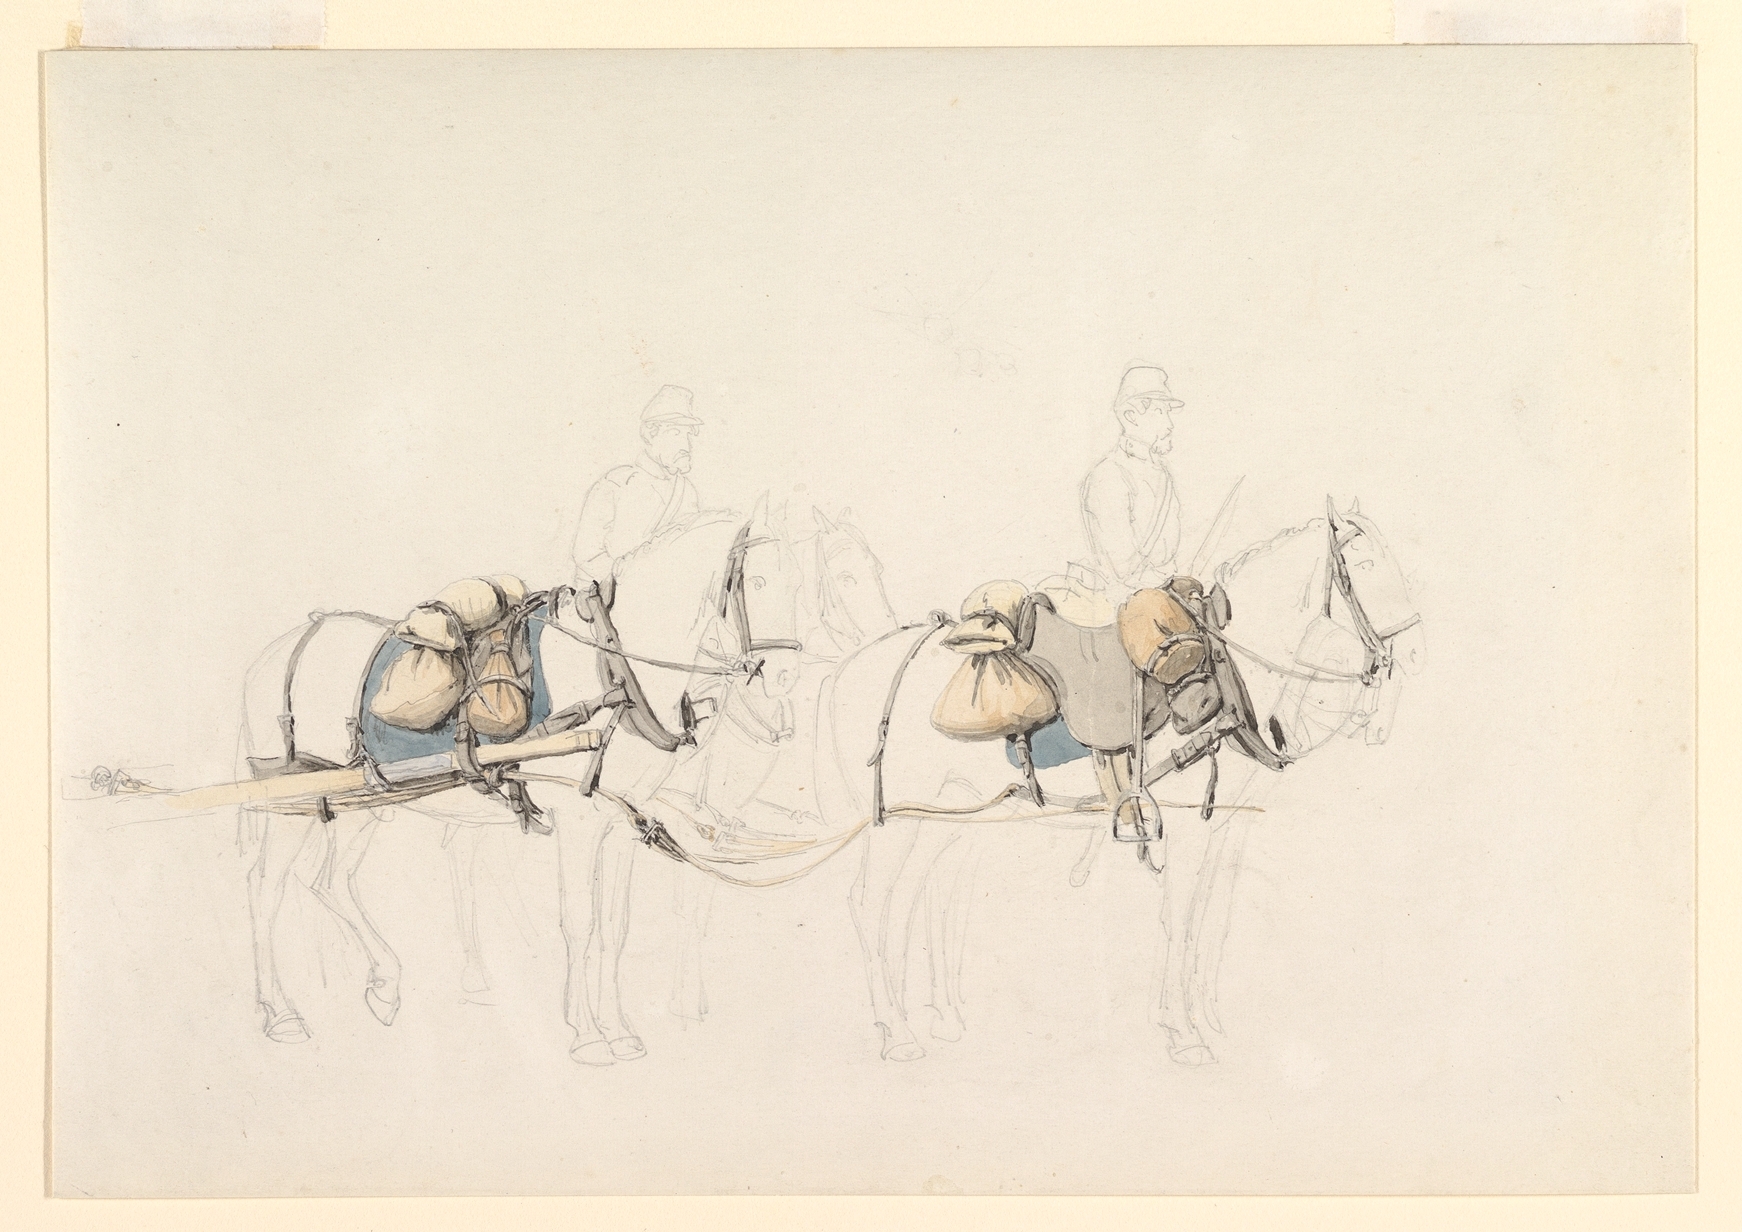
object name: drawing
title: Studies of Four Horses with Two Horsemen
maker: jörgen valentin sonne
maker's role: artist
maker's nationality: danish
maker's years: 1801-1890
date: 1848-1851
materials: graphite, watercolor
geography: denmark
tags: men,horses